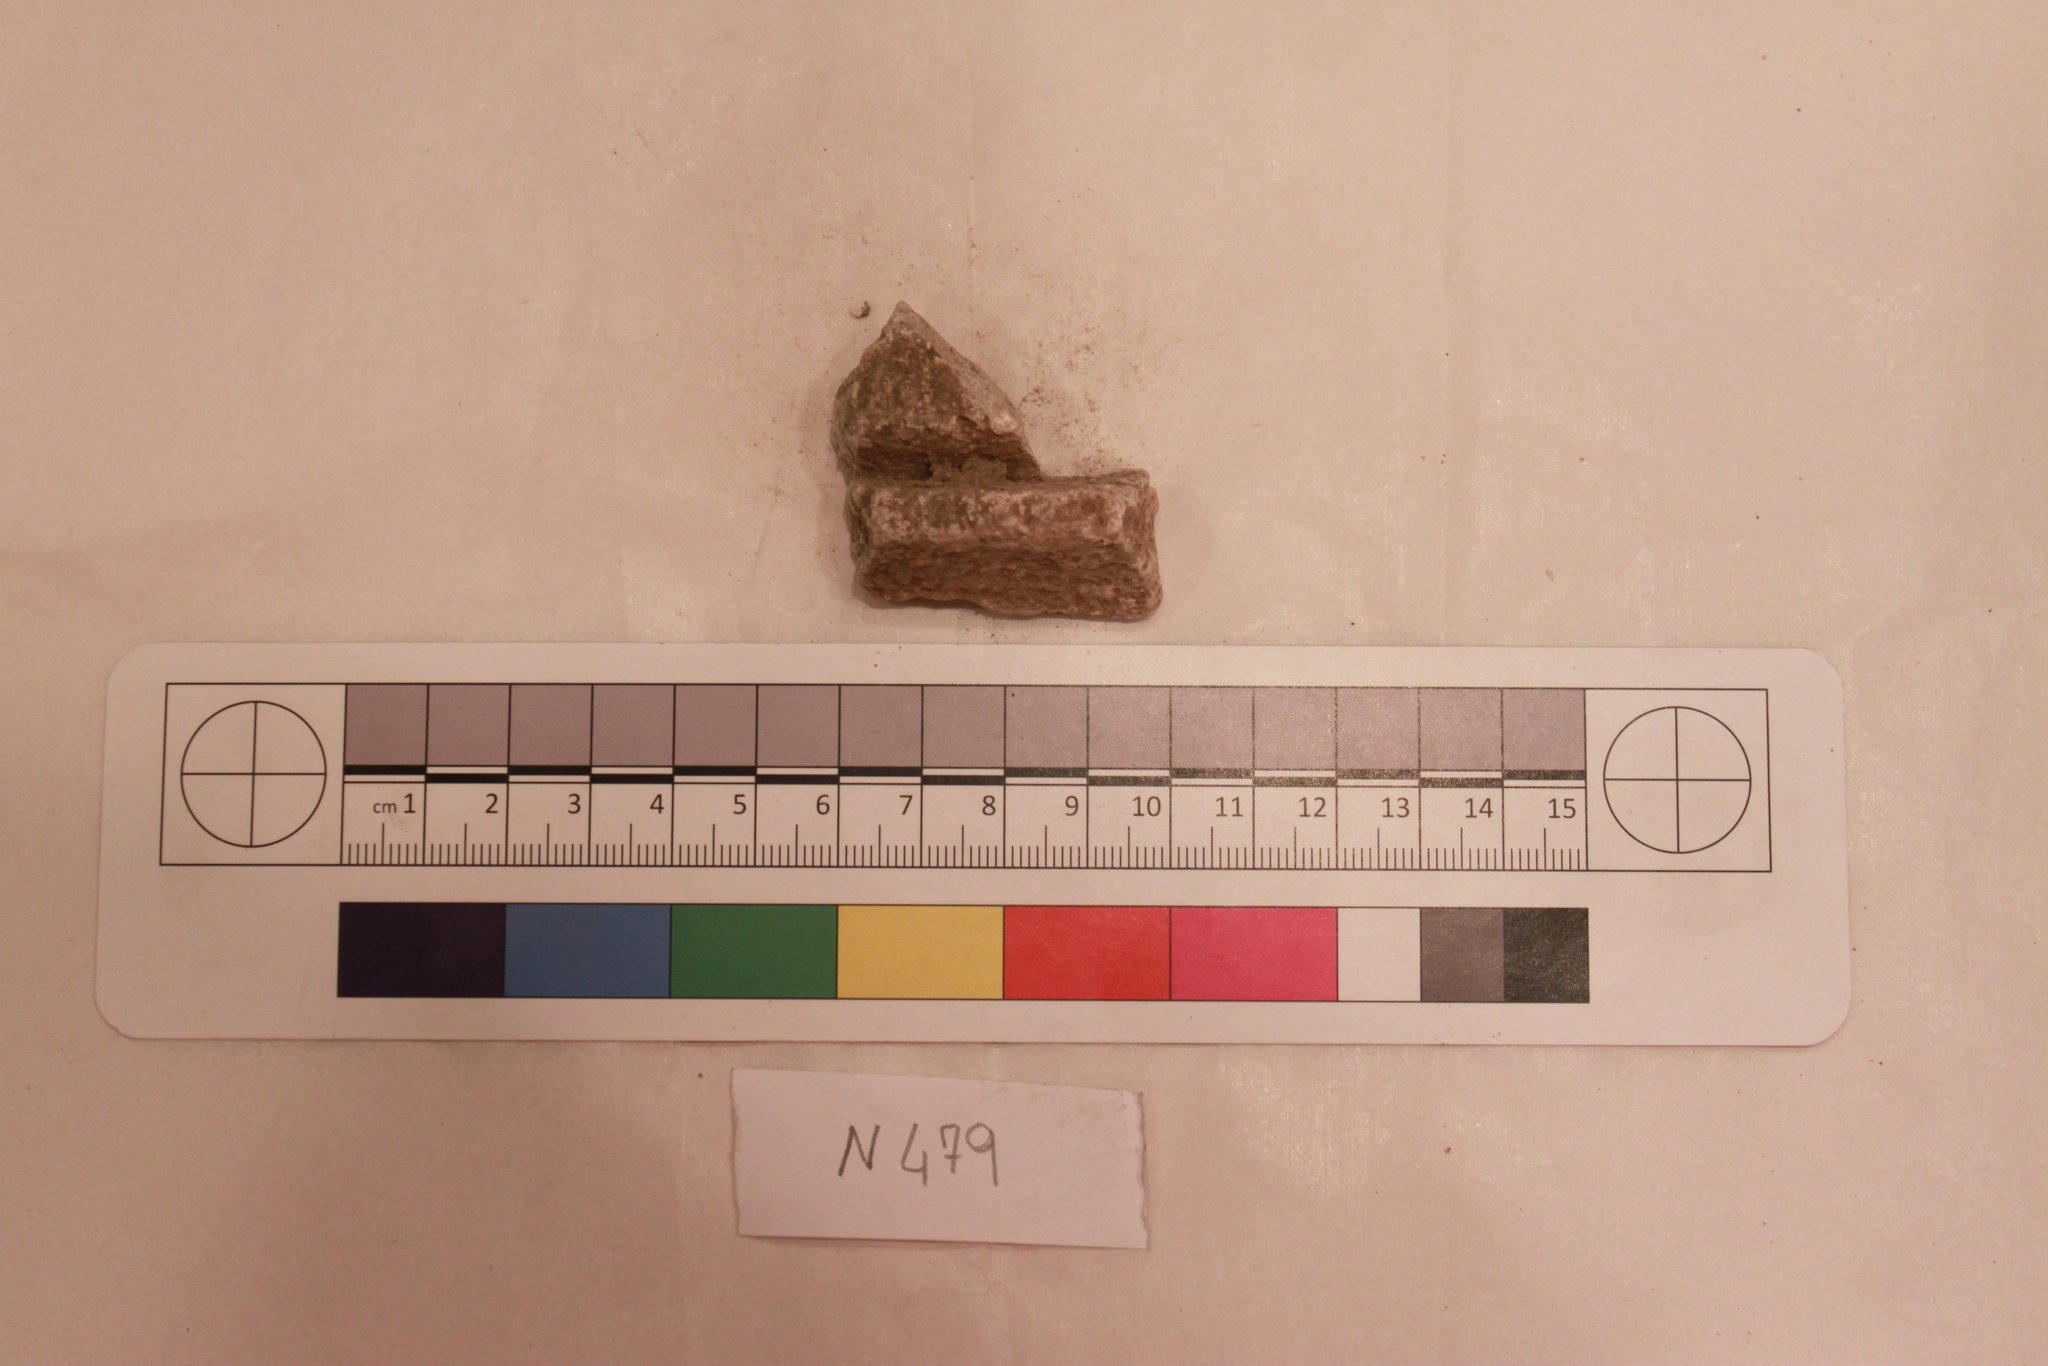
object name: fragment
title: Stucco Fragment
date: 701-1200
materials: plaster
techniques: carving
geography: iran